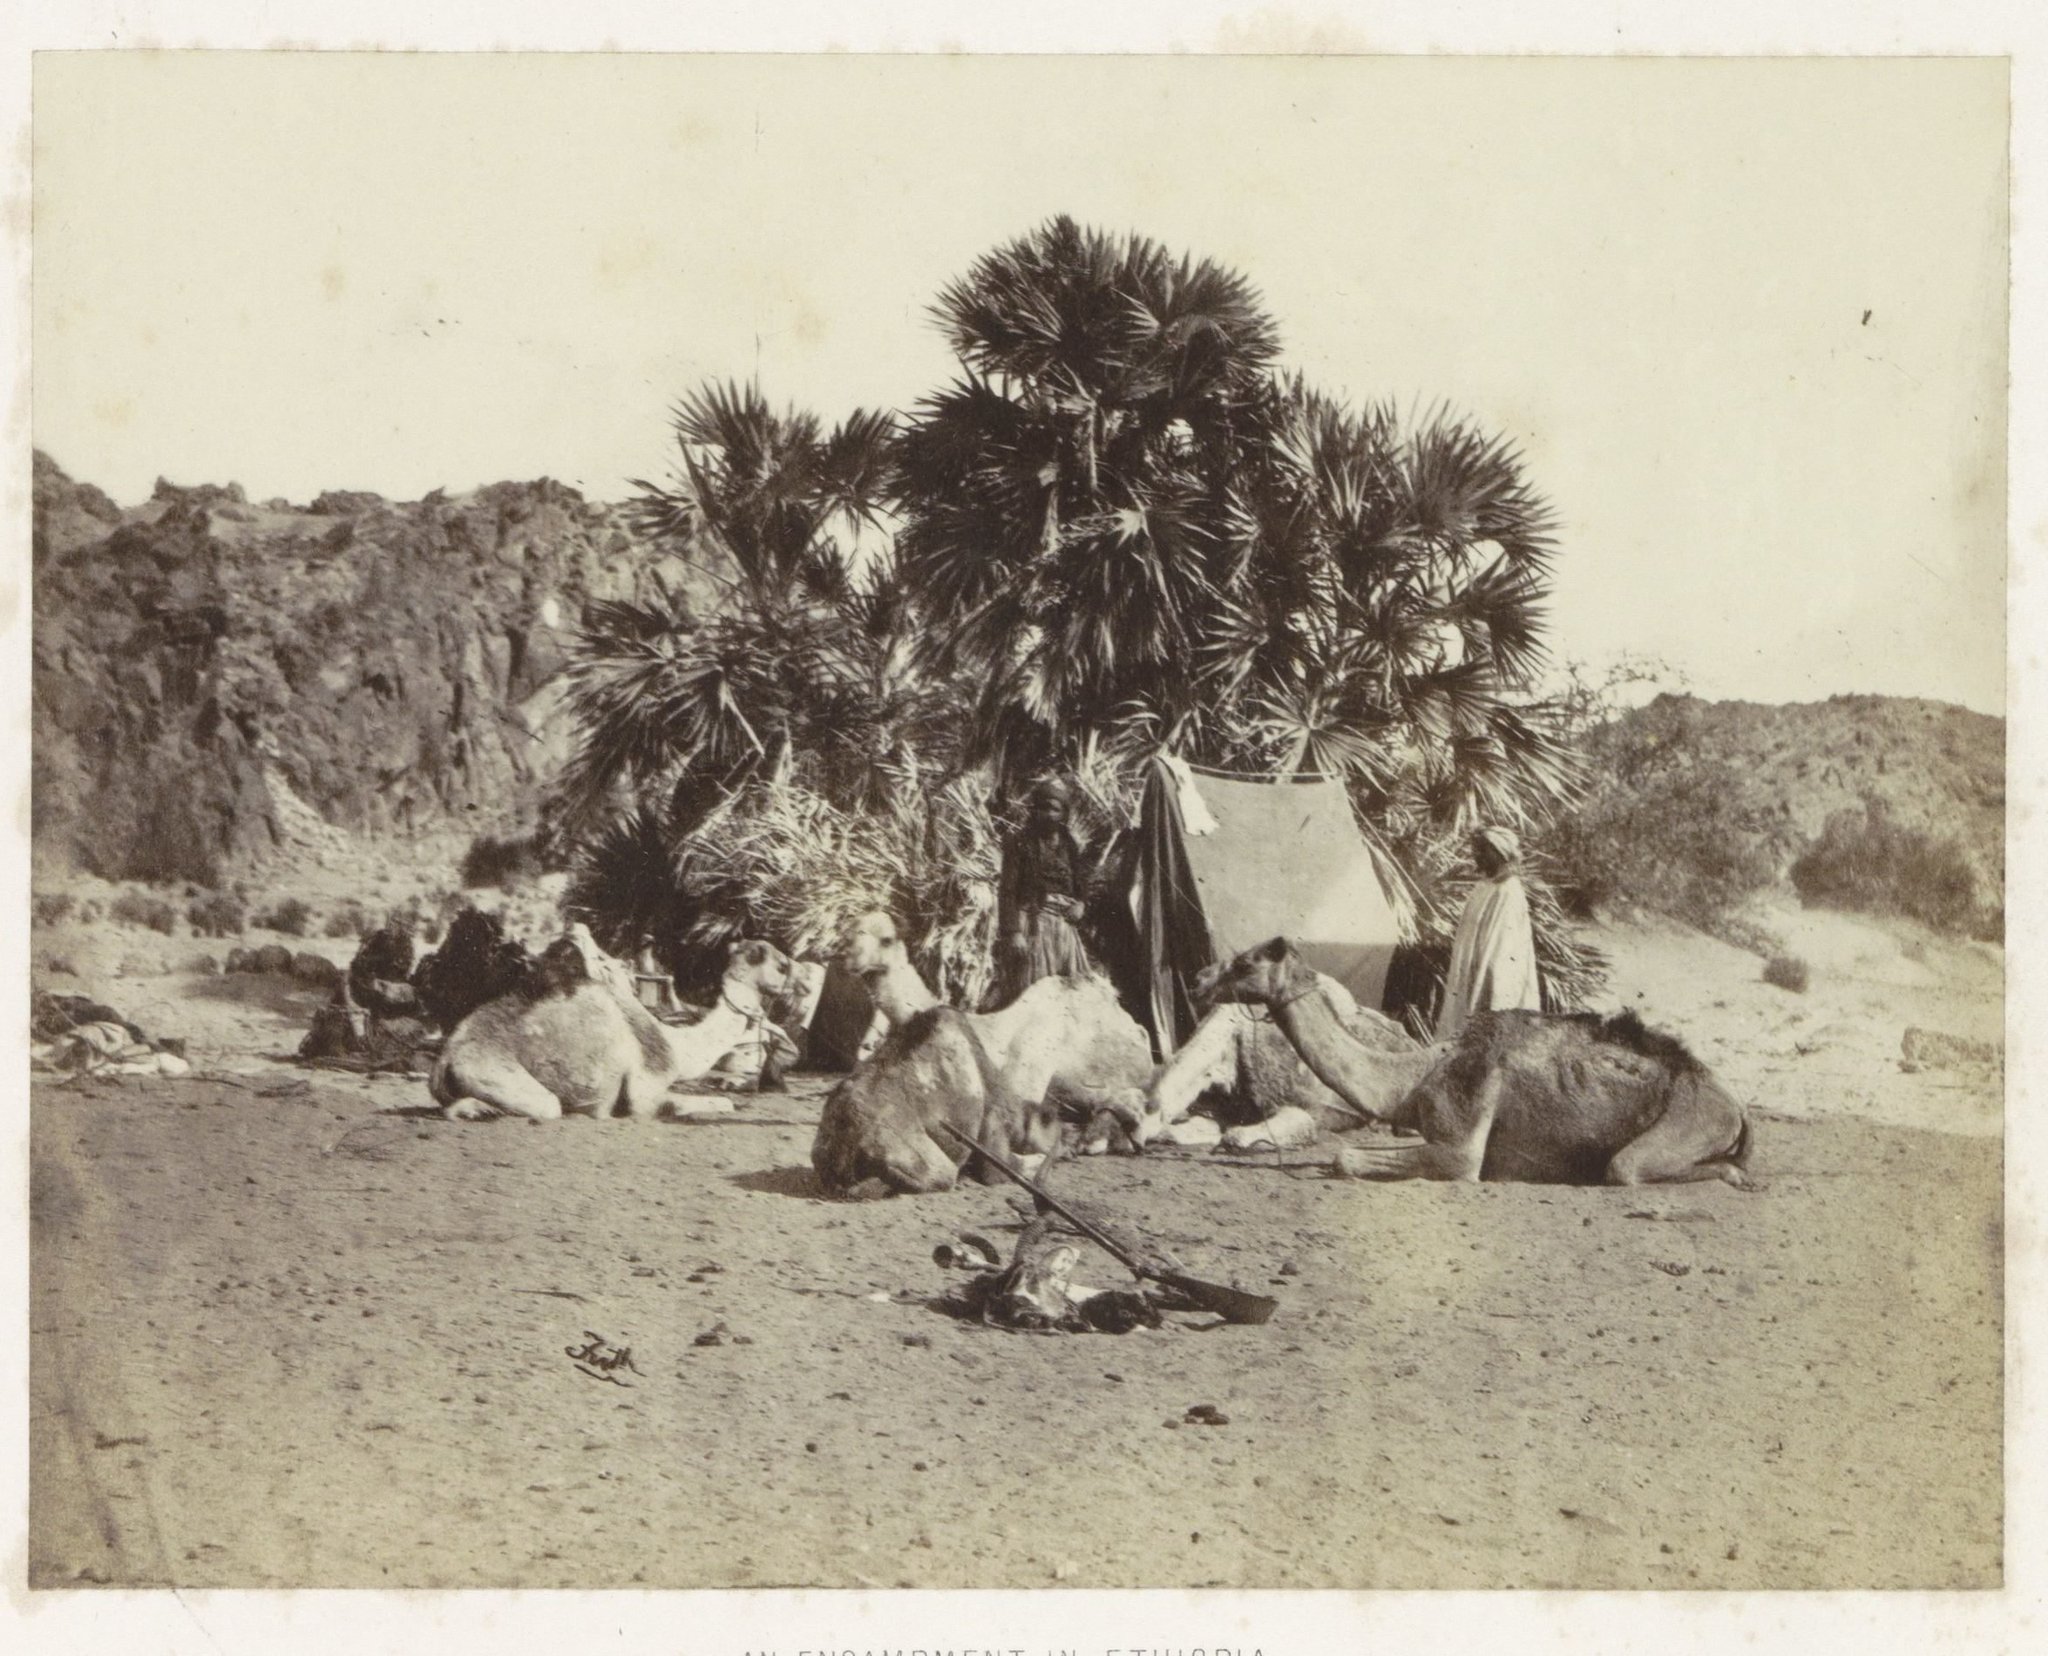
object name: photograph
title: Kampement in Ethiopië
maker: francis frith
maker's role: publisher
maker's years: 1822-1898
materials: paper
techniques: albumen print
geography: ethiopia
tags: hoofed animals: dromedary, tent-camp, trees: palm-tree